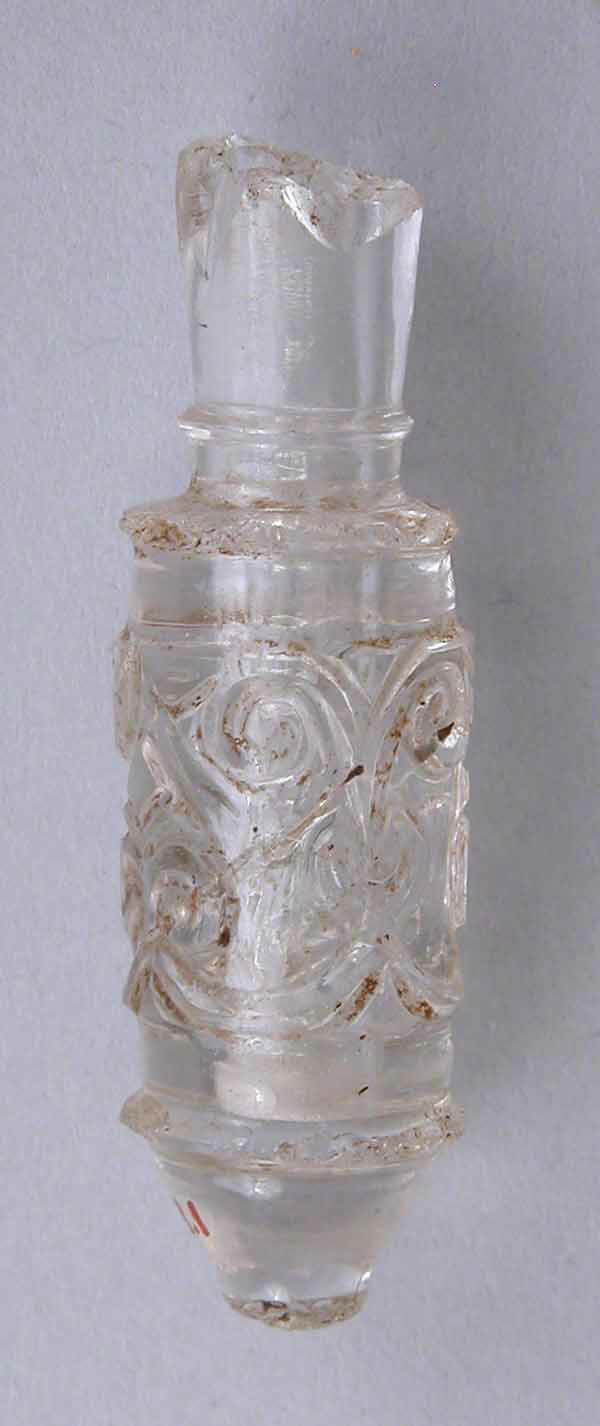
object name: flask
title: Crystal Flask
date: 801-1000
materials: quartz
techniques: carving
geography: egypt